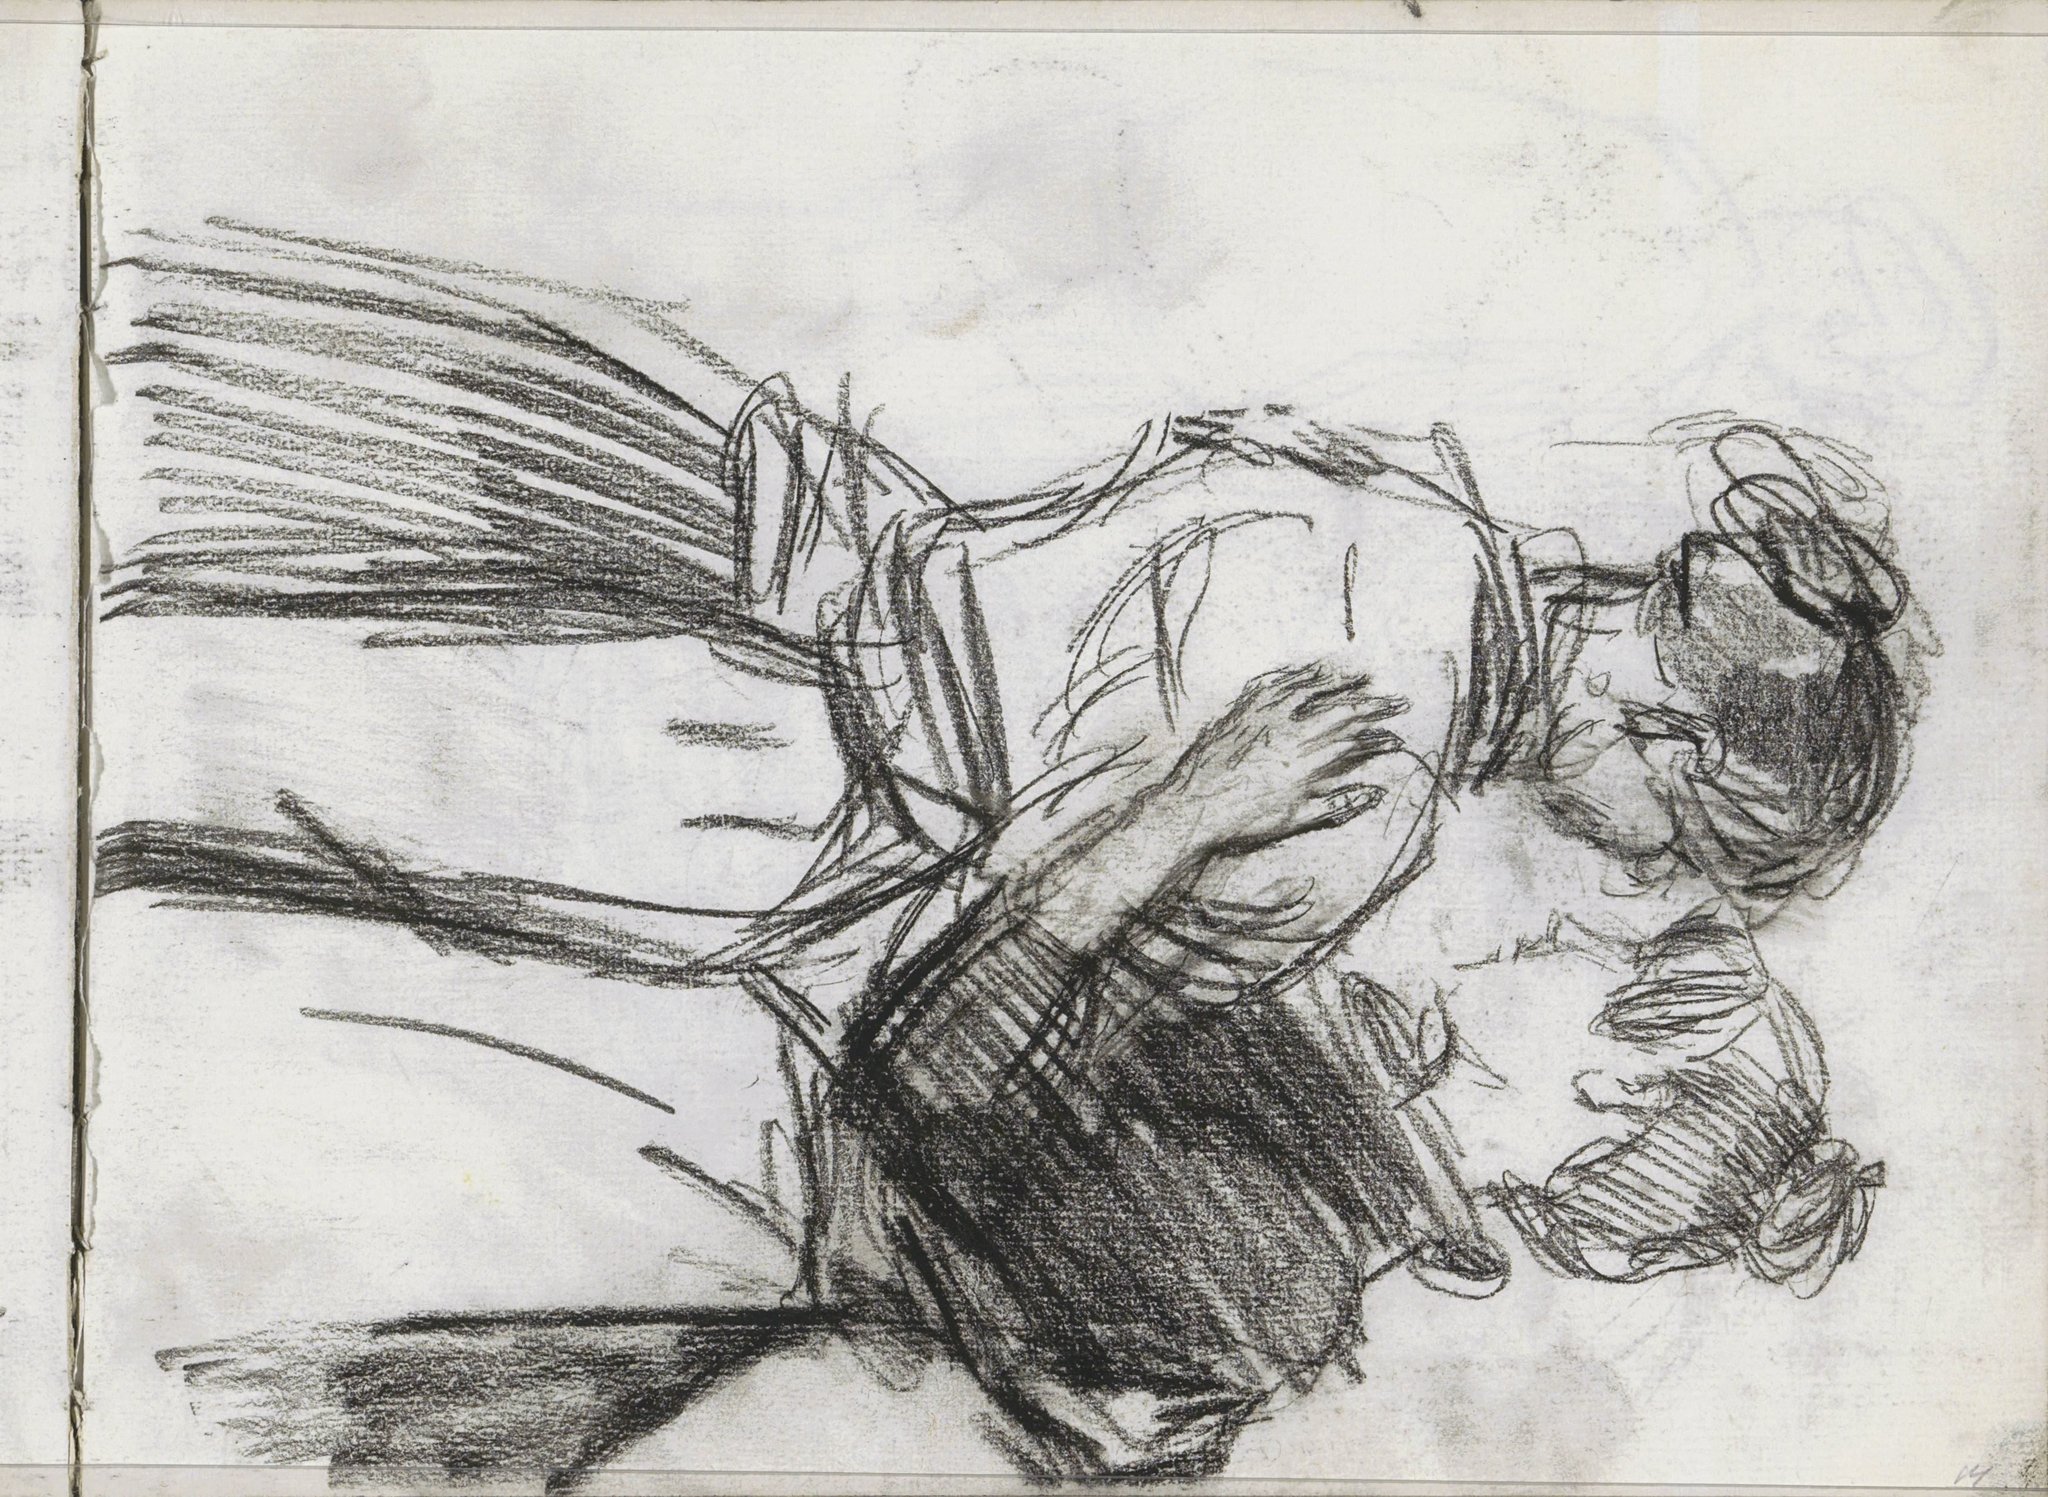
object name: sketchbook leaf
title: Twee dansende vrouwen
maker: isaac israels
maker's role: draughtsman, painter, print maker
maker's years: 1865-1934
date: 1875-1934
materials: chalk, paper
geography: amsterdam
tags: two women dancing as a couple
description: Blad 14 recto uit schetsboek XX met 26 bladen.